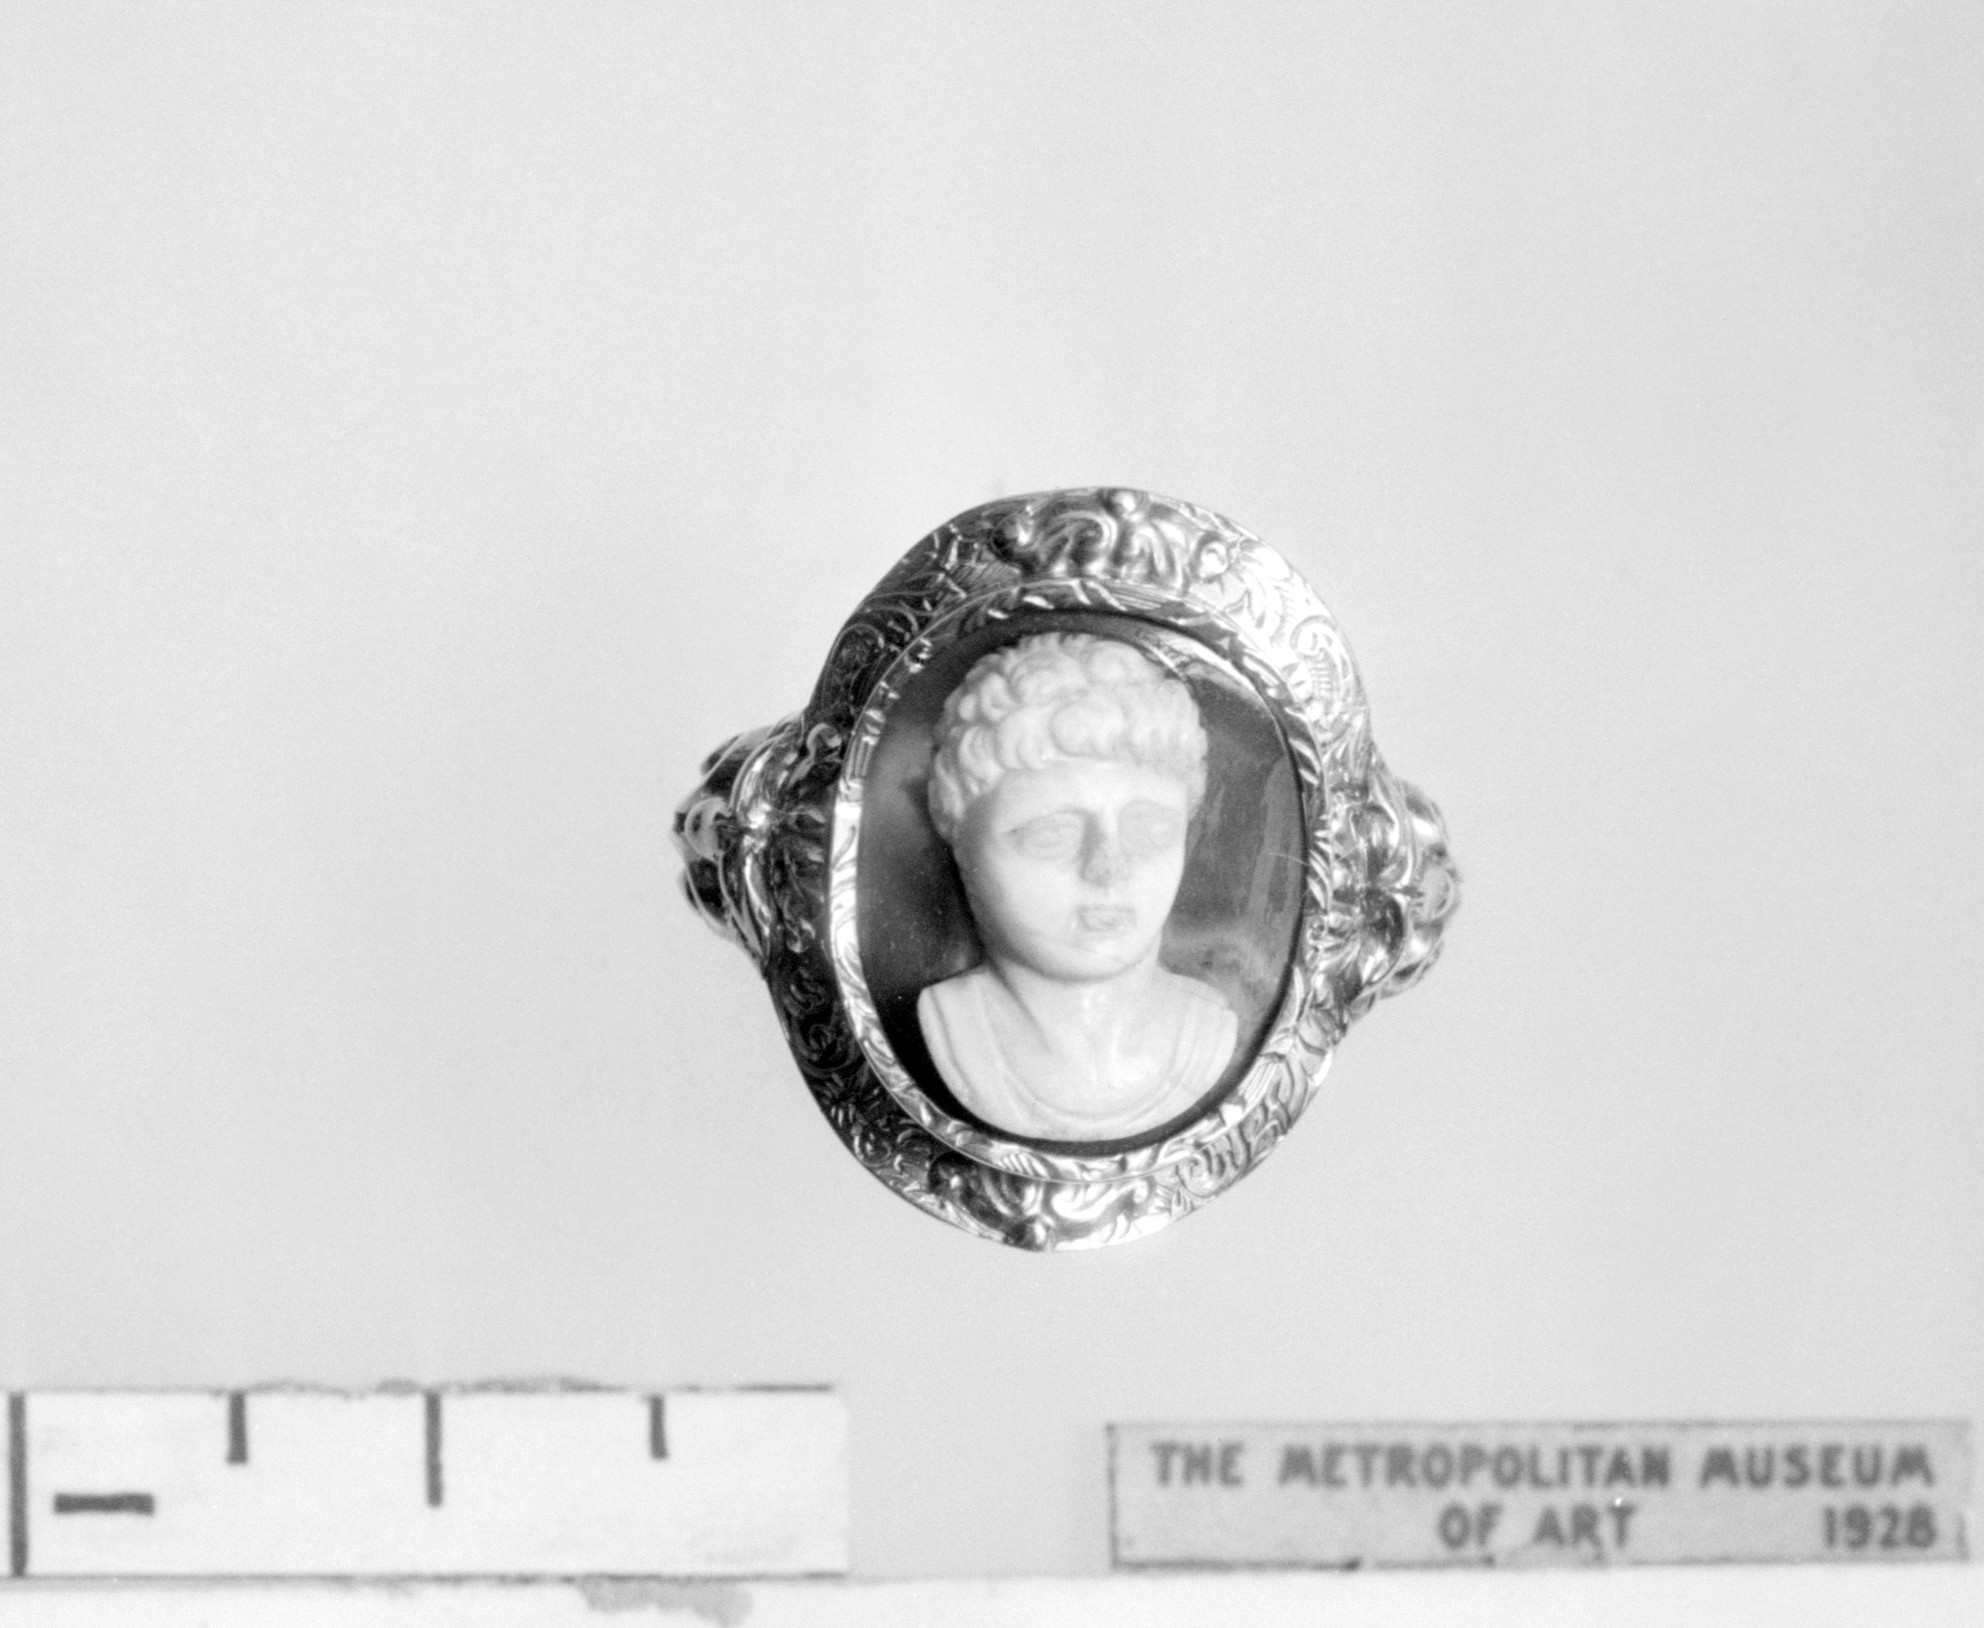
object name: cameo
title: Head of a man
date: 1501-1700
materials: gold, gemstone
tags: men,portraits